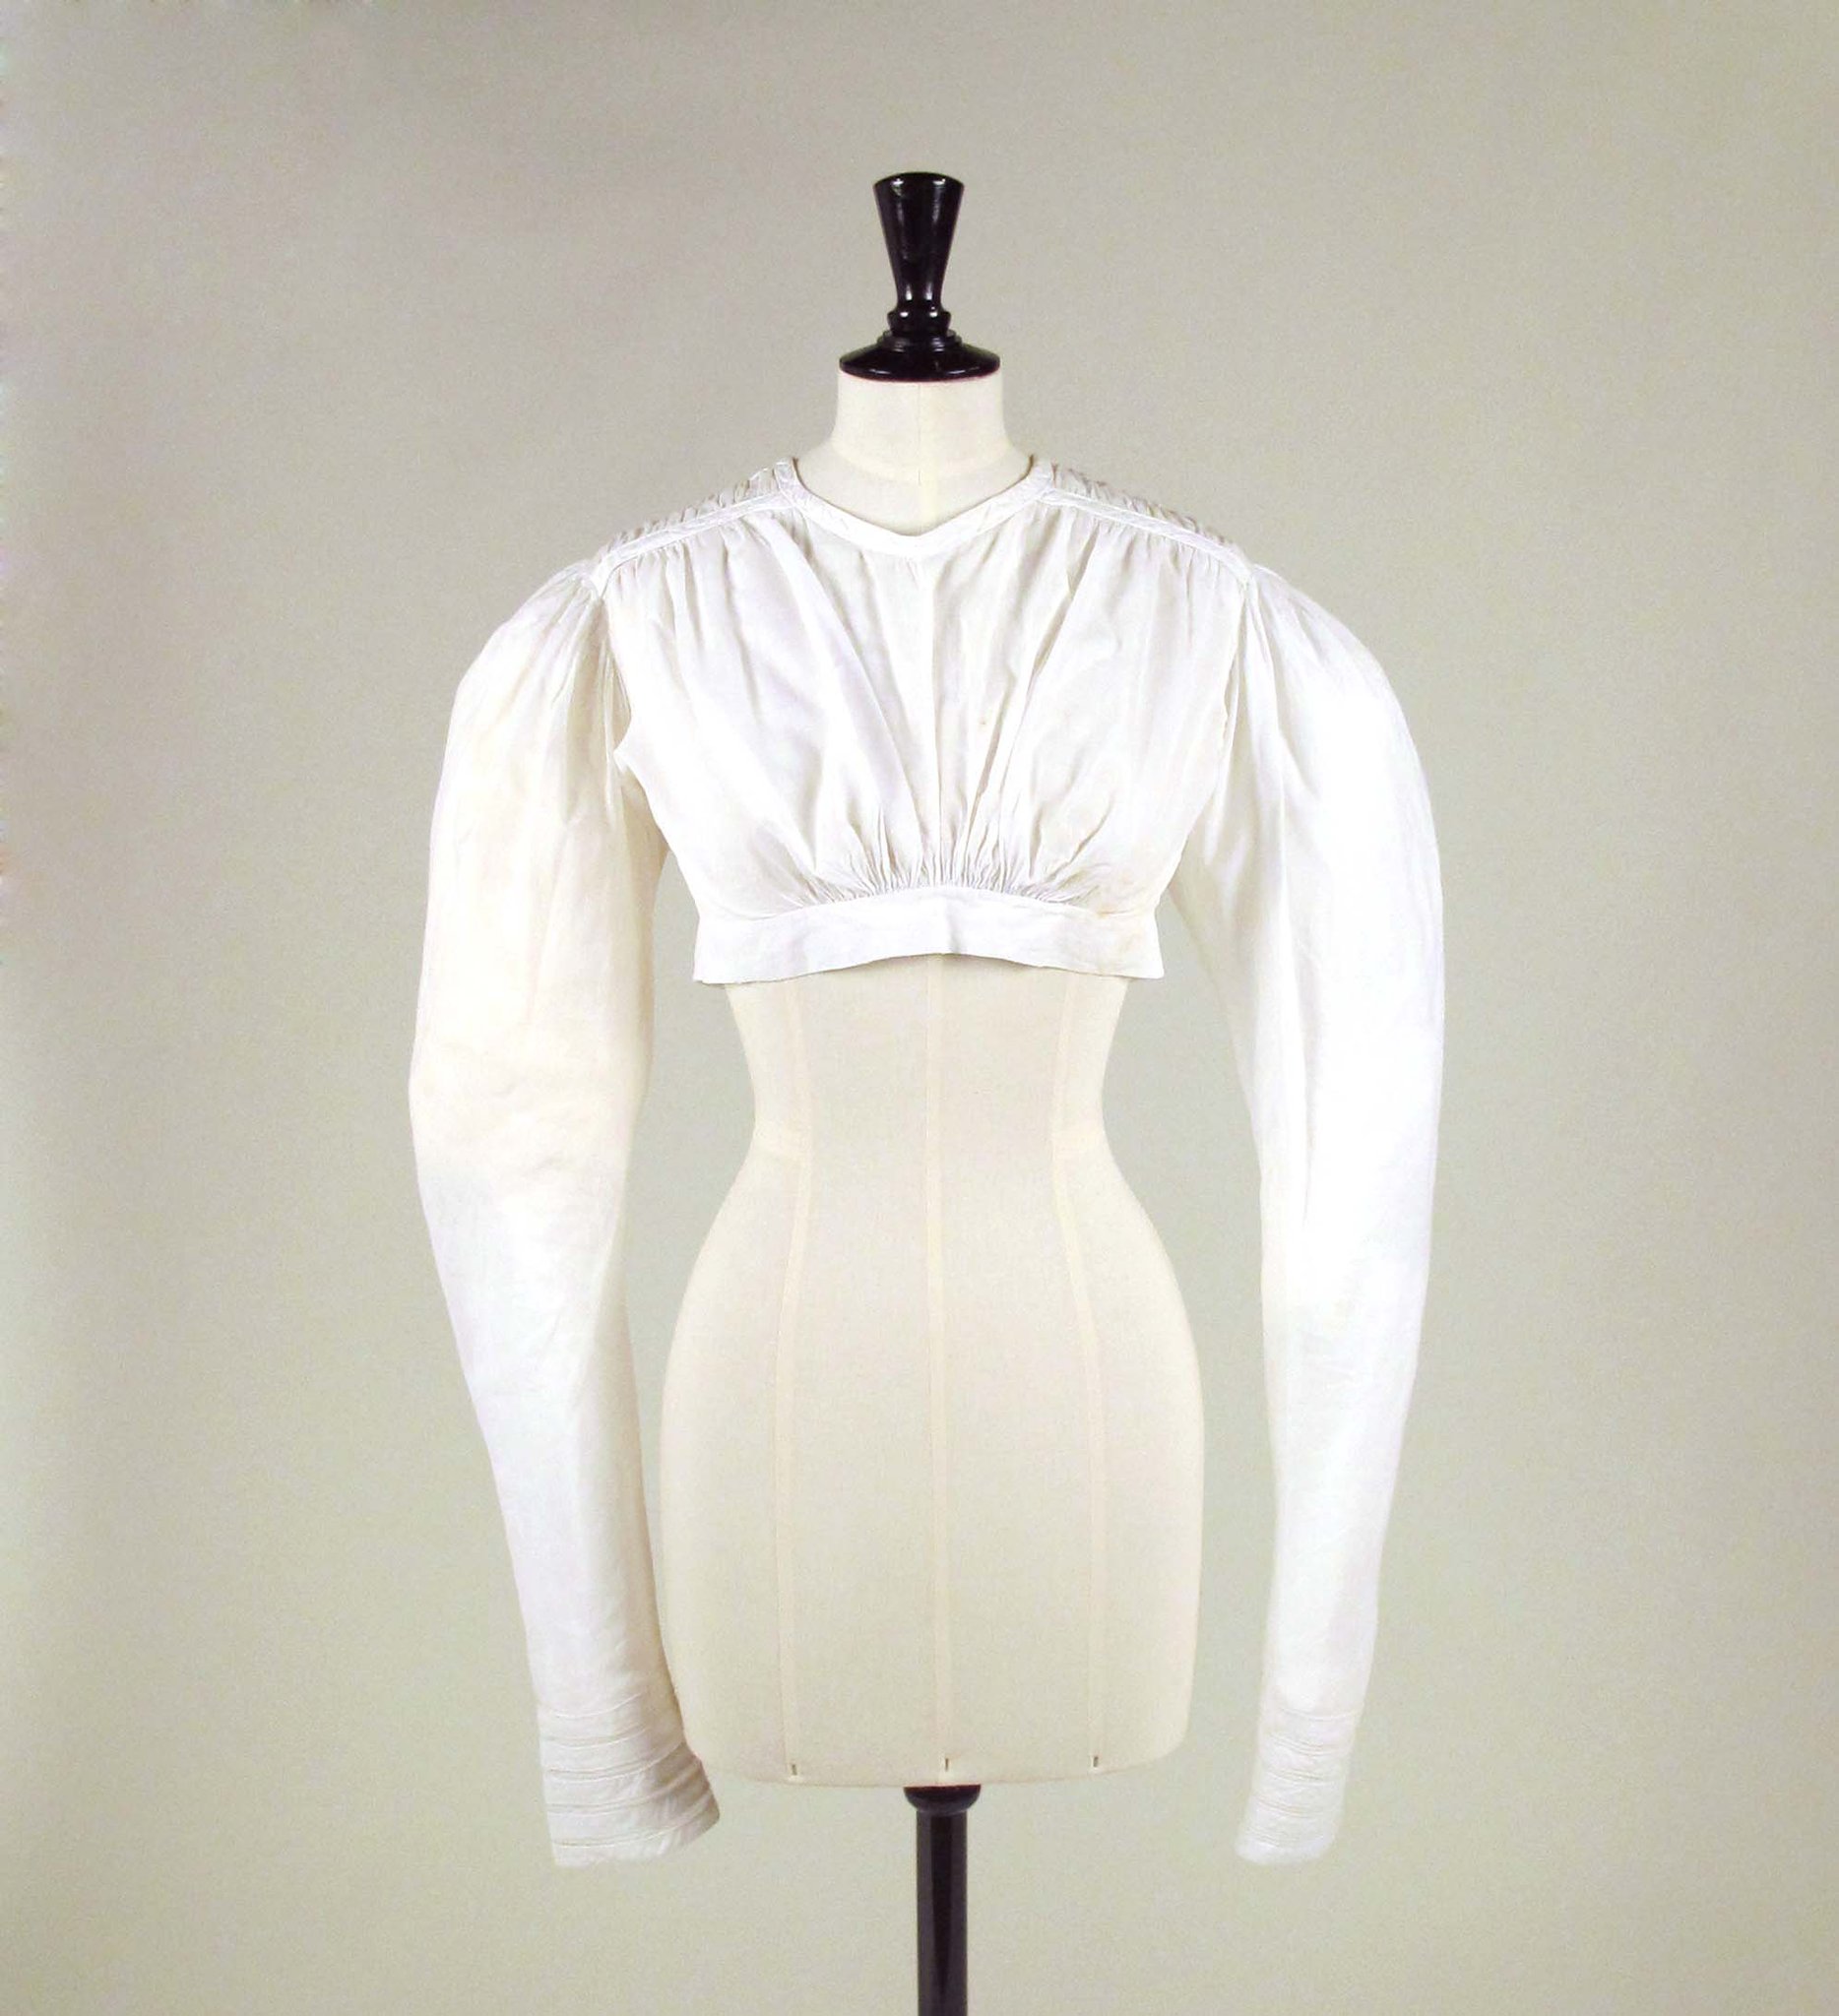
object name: bodice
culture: french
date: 1820-1825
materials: cotton